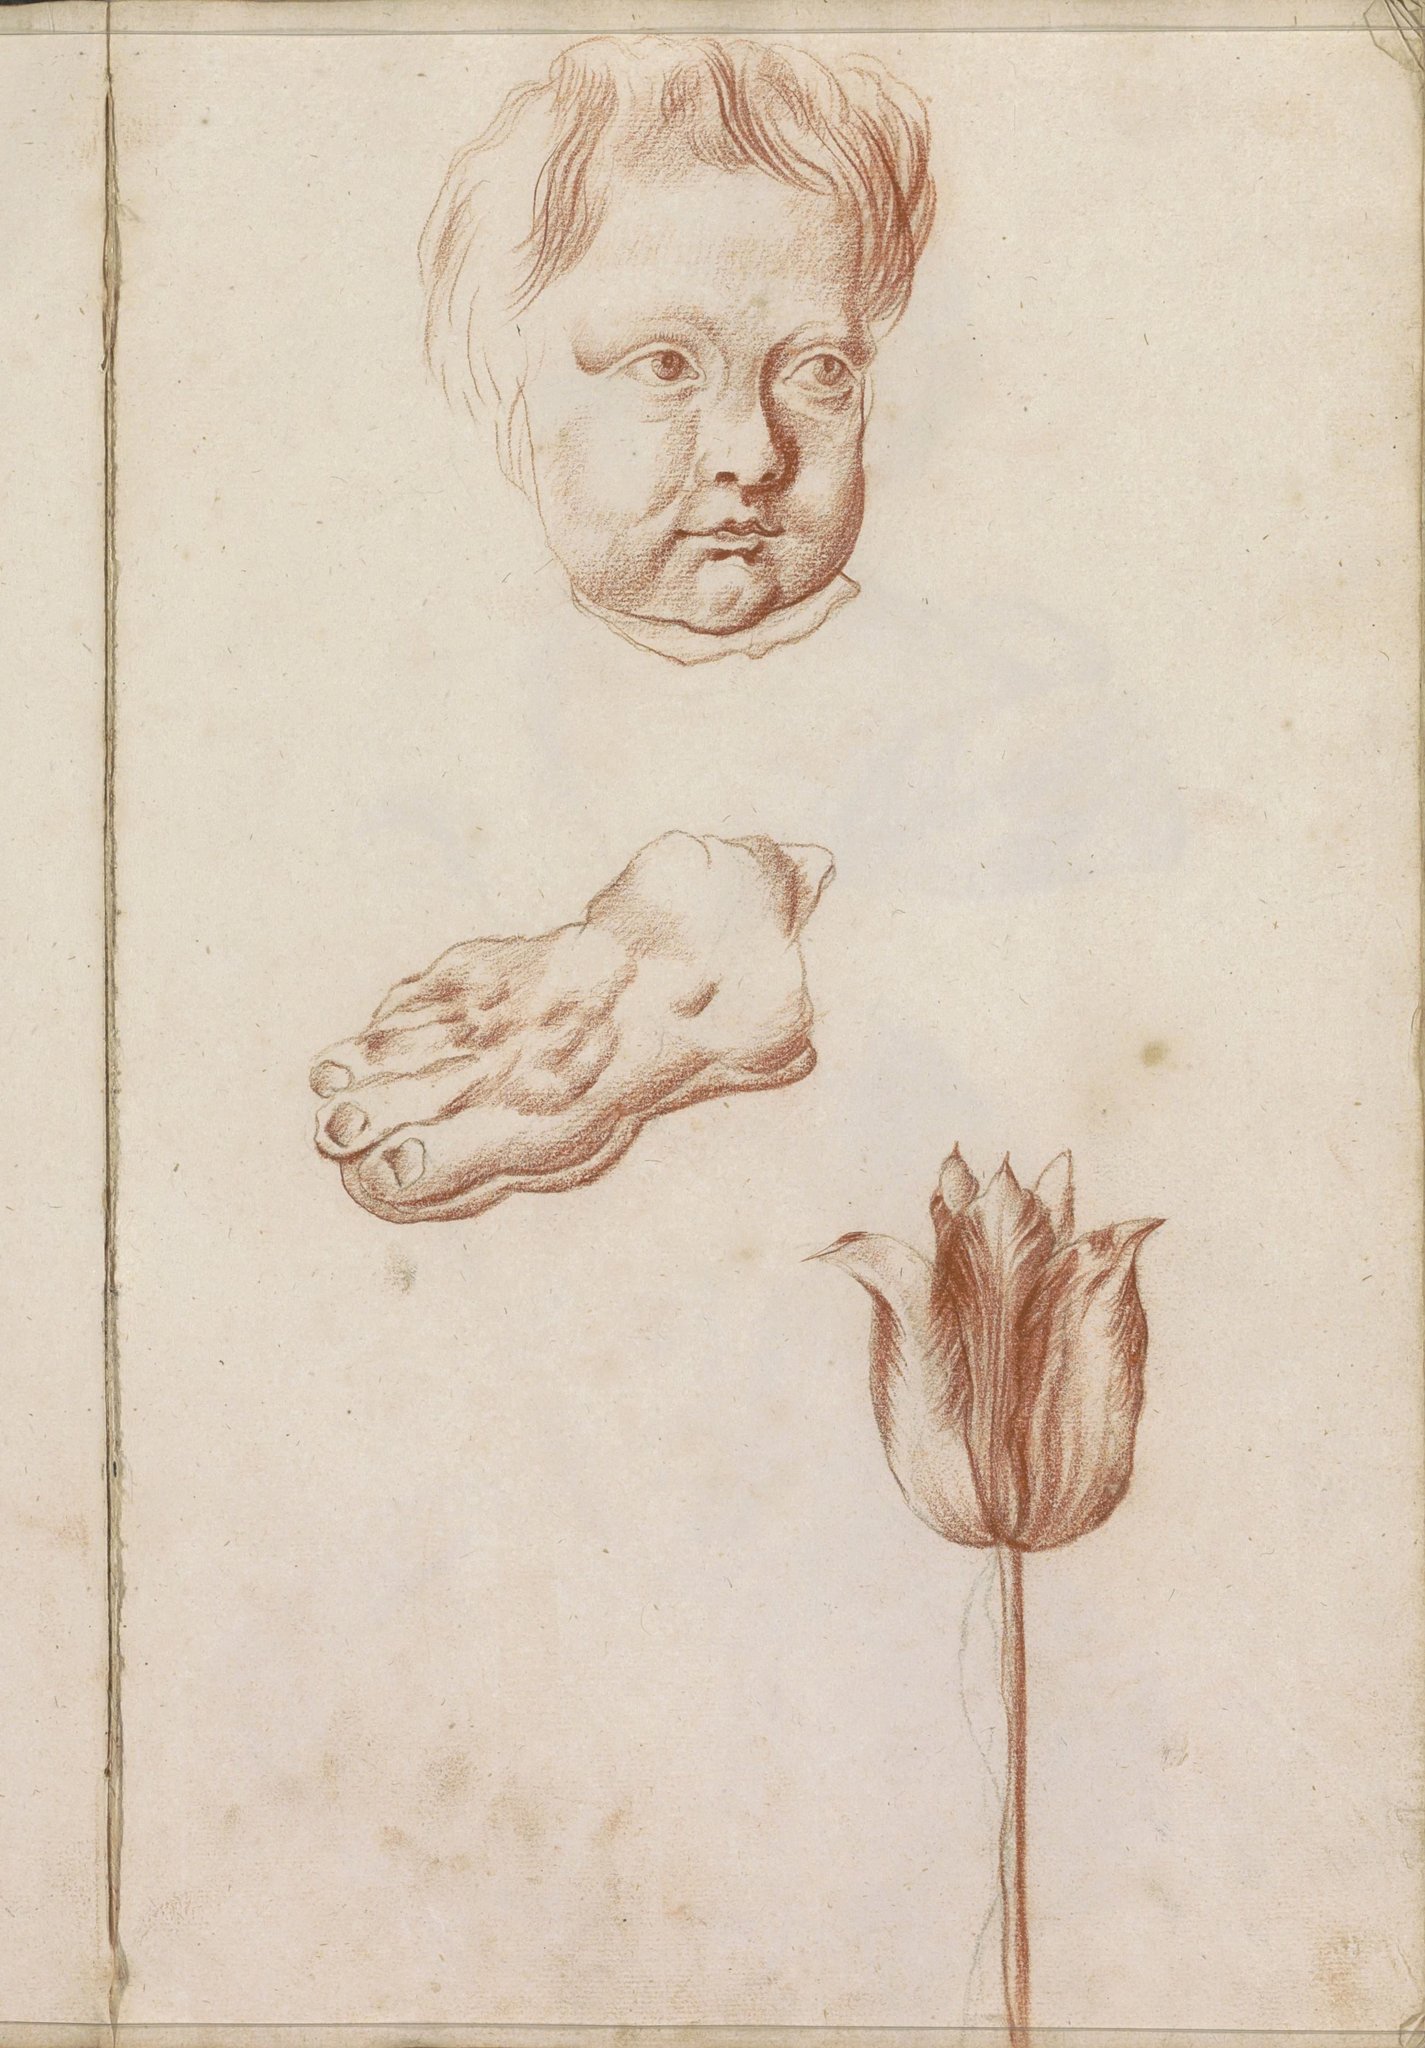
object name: sketchbook leaf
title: Hoofd van een kind, een voet en een tulp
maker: hendrick van beaumont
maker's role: draughtsman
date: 1696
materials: chalk, paper, pencil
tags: child, foot, flowers: tulip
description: Mogelijk getekend naar prenten. Blad 21 recto uit een schetsboek met 91 bladen.